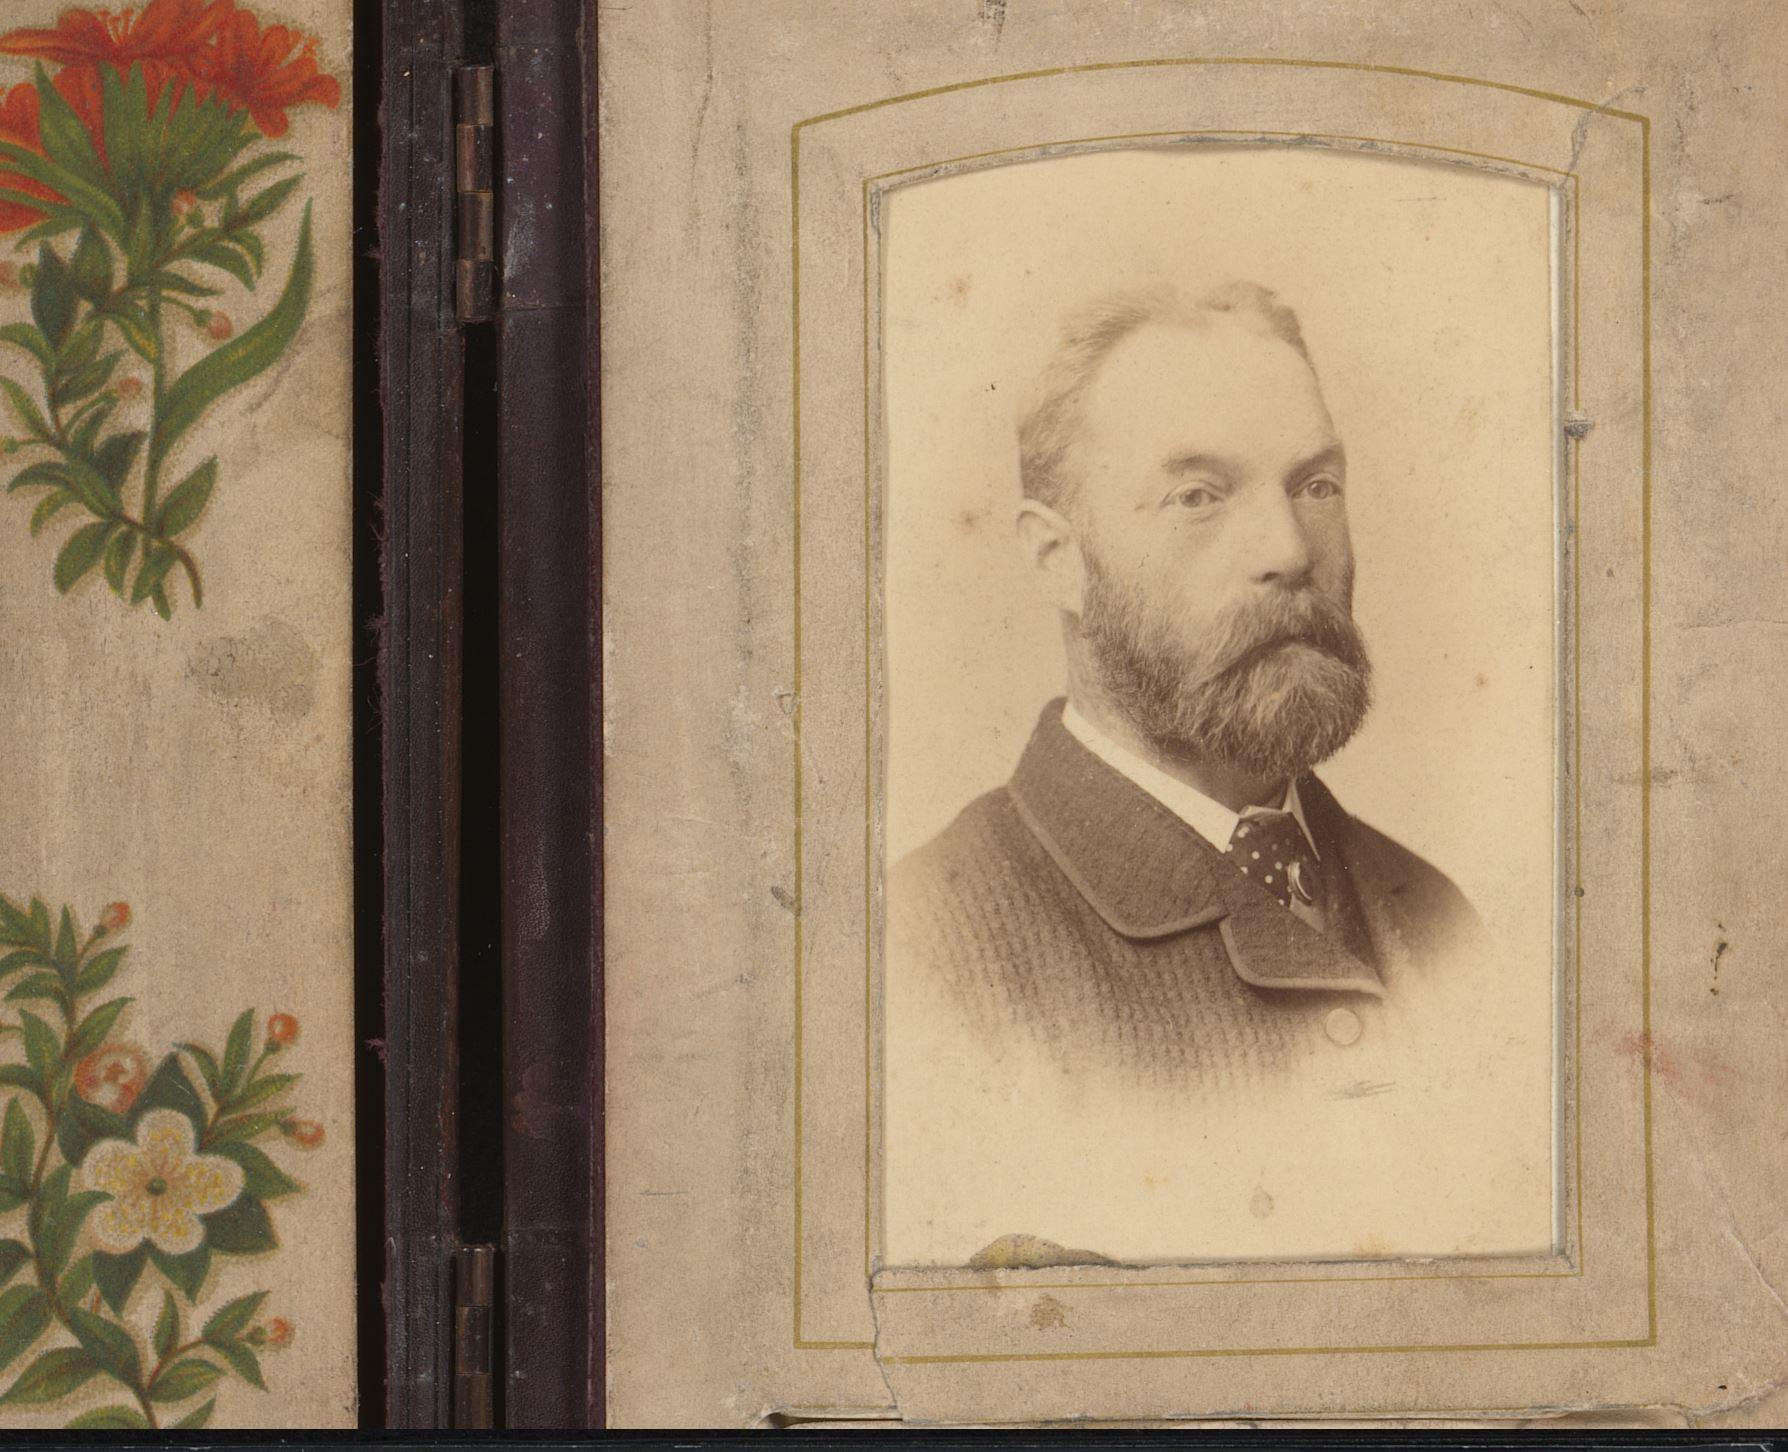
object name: photograph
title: Portret van een man met baard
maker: Anonymous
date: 1870-1880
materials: cardboard, photographic support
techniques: albumen print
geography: england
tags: historical persons, beard